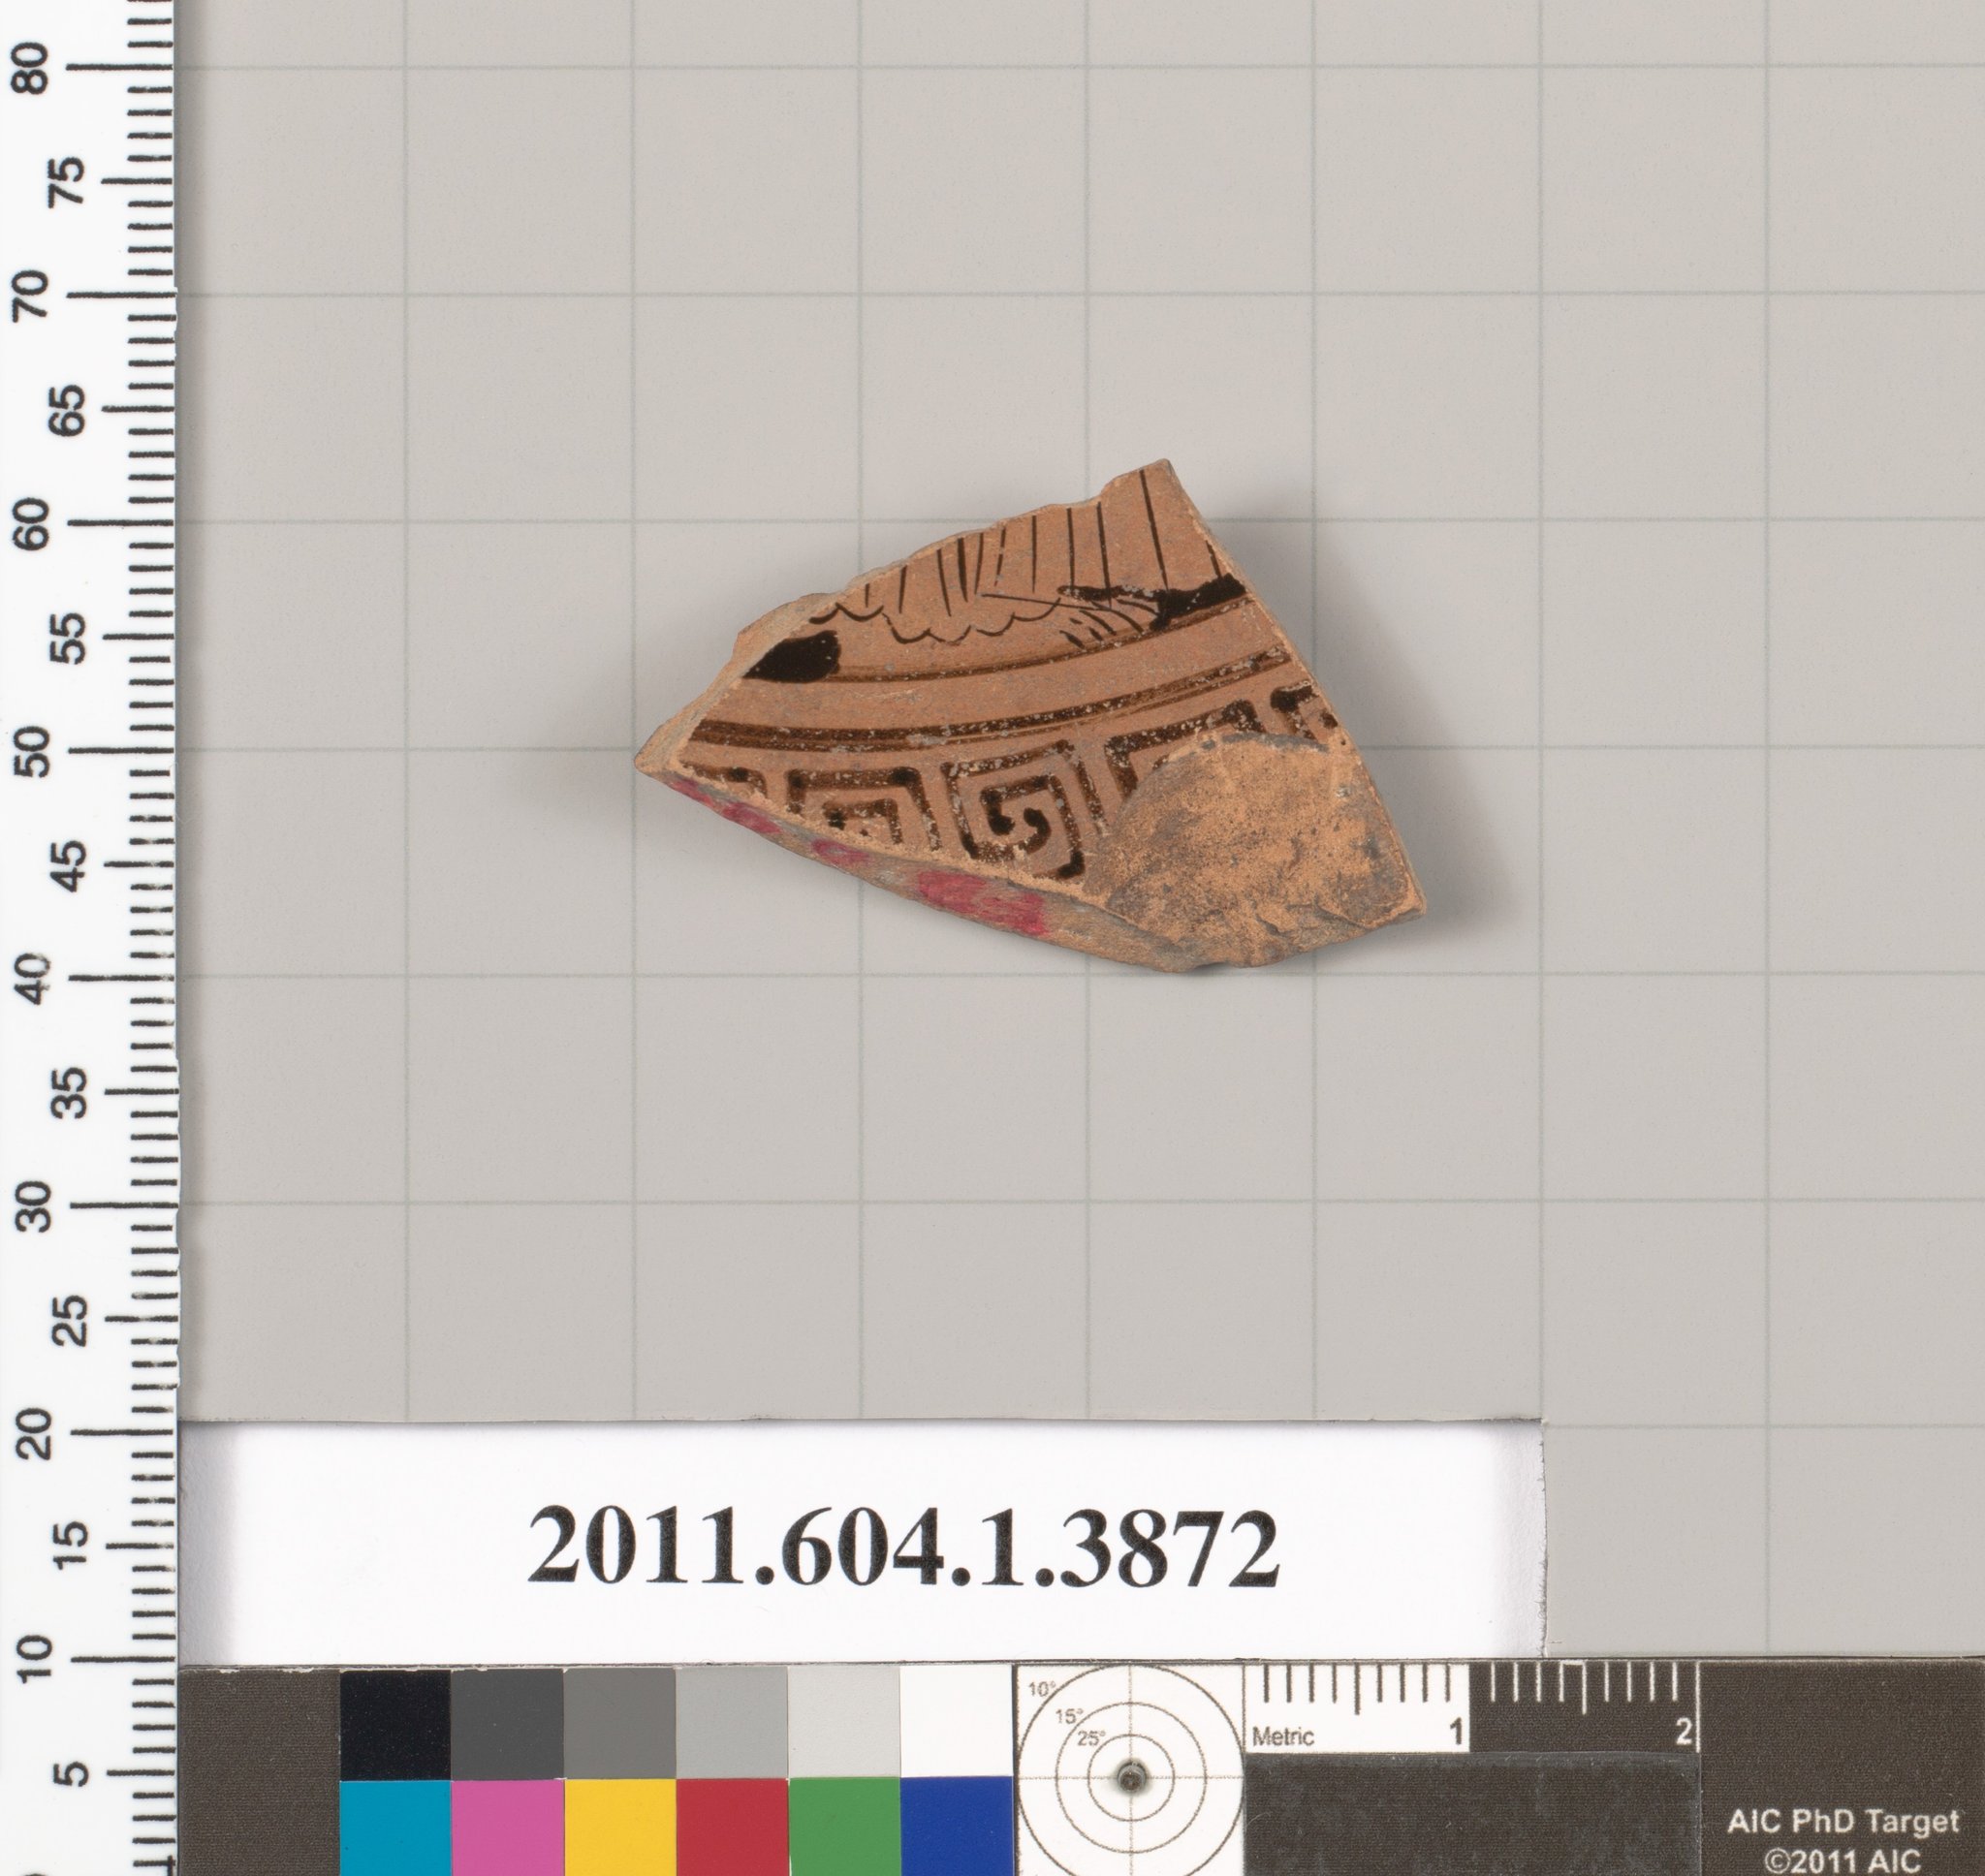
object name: kylix fragment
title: Terracotta fragment of a kylix (drinking cup)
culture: greek, attic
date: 475-451 BCE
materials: terracotta